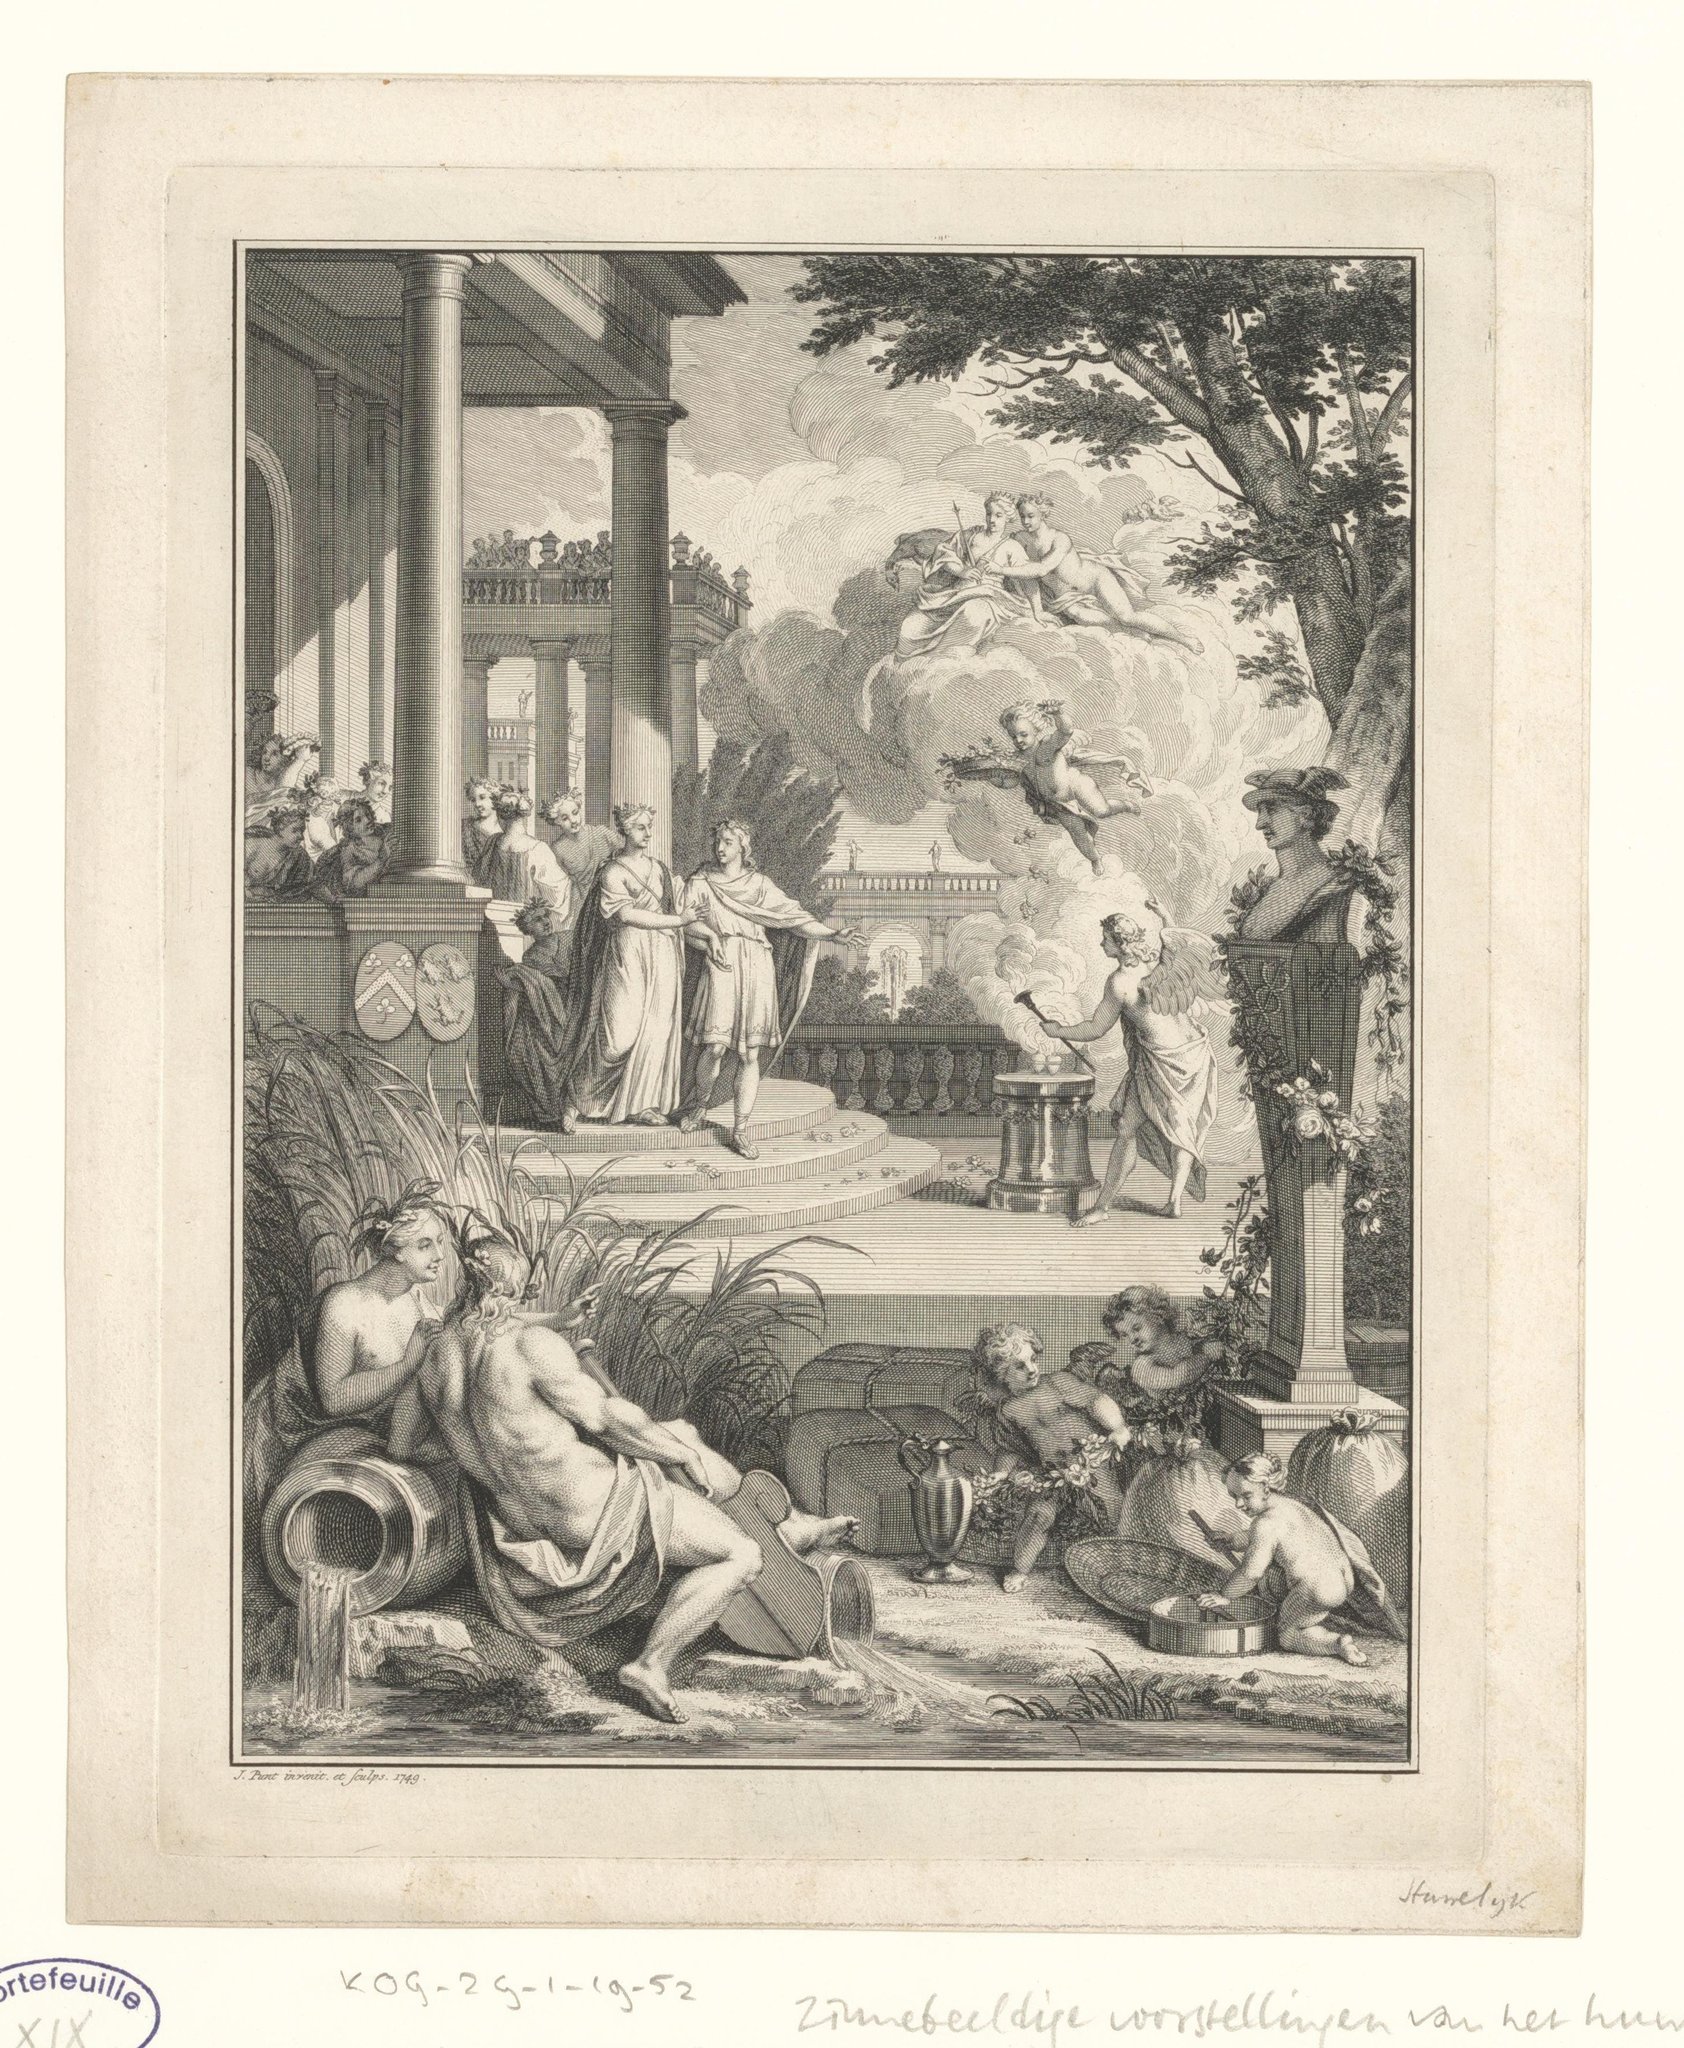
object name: print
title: Bruiloftsprent, 1749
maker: jan punt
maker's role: draughtsman, print maker, publisher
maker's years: 1711-1779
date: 1749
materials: paper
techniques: engraving, etching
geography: netherlands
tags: (civil) marriage ceremonies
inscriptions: collector's mark: Lugt 1641, collector's mark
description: Bruiloftsprent uit 1749 met een allegorische voorstelling van een huwelijk. Het bruidspaar op de trappen naar een terras waar een altaar brandt. Op een voetstuk de twee familiewapens. Op de voorgrond riviergoden. Onderwerpsrubrieken binnen de Atlas Zeden en Gewoonten: Des Menschen Begin, Midden en Einde. Bruiloft en huwelijk.